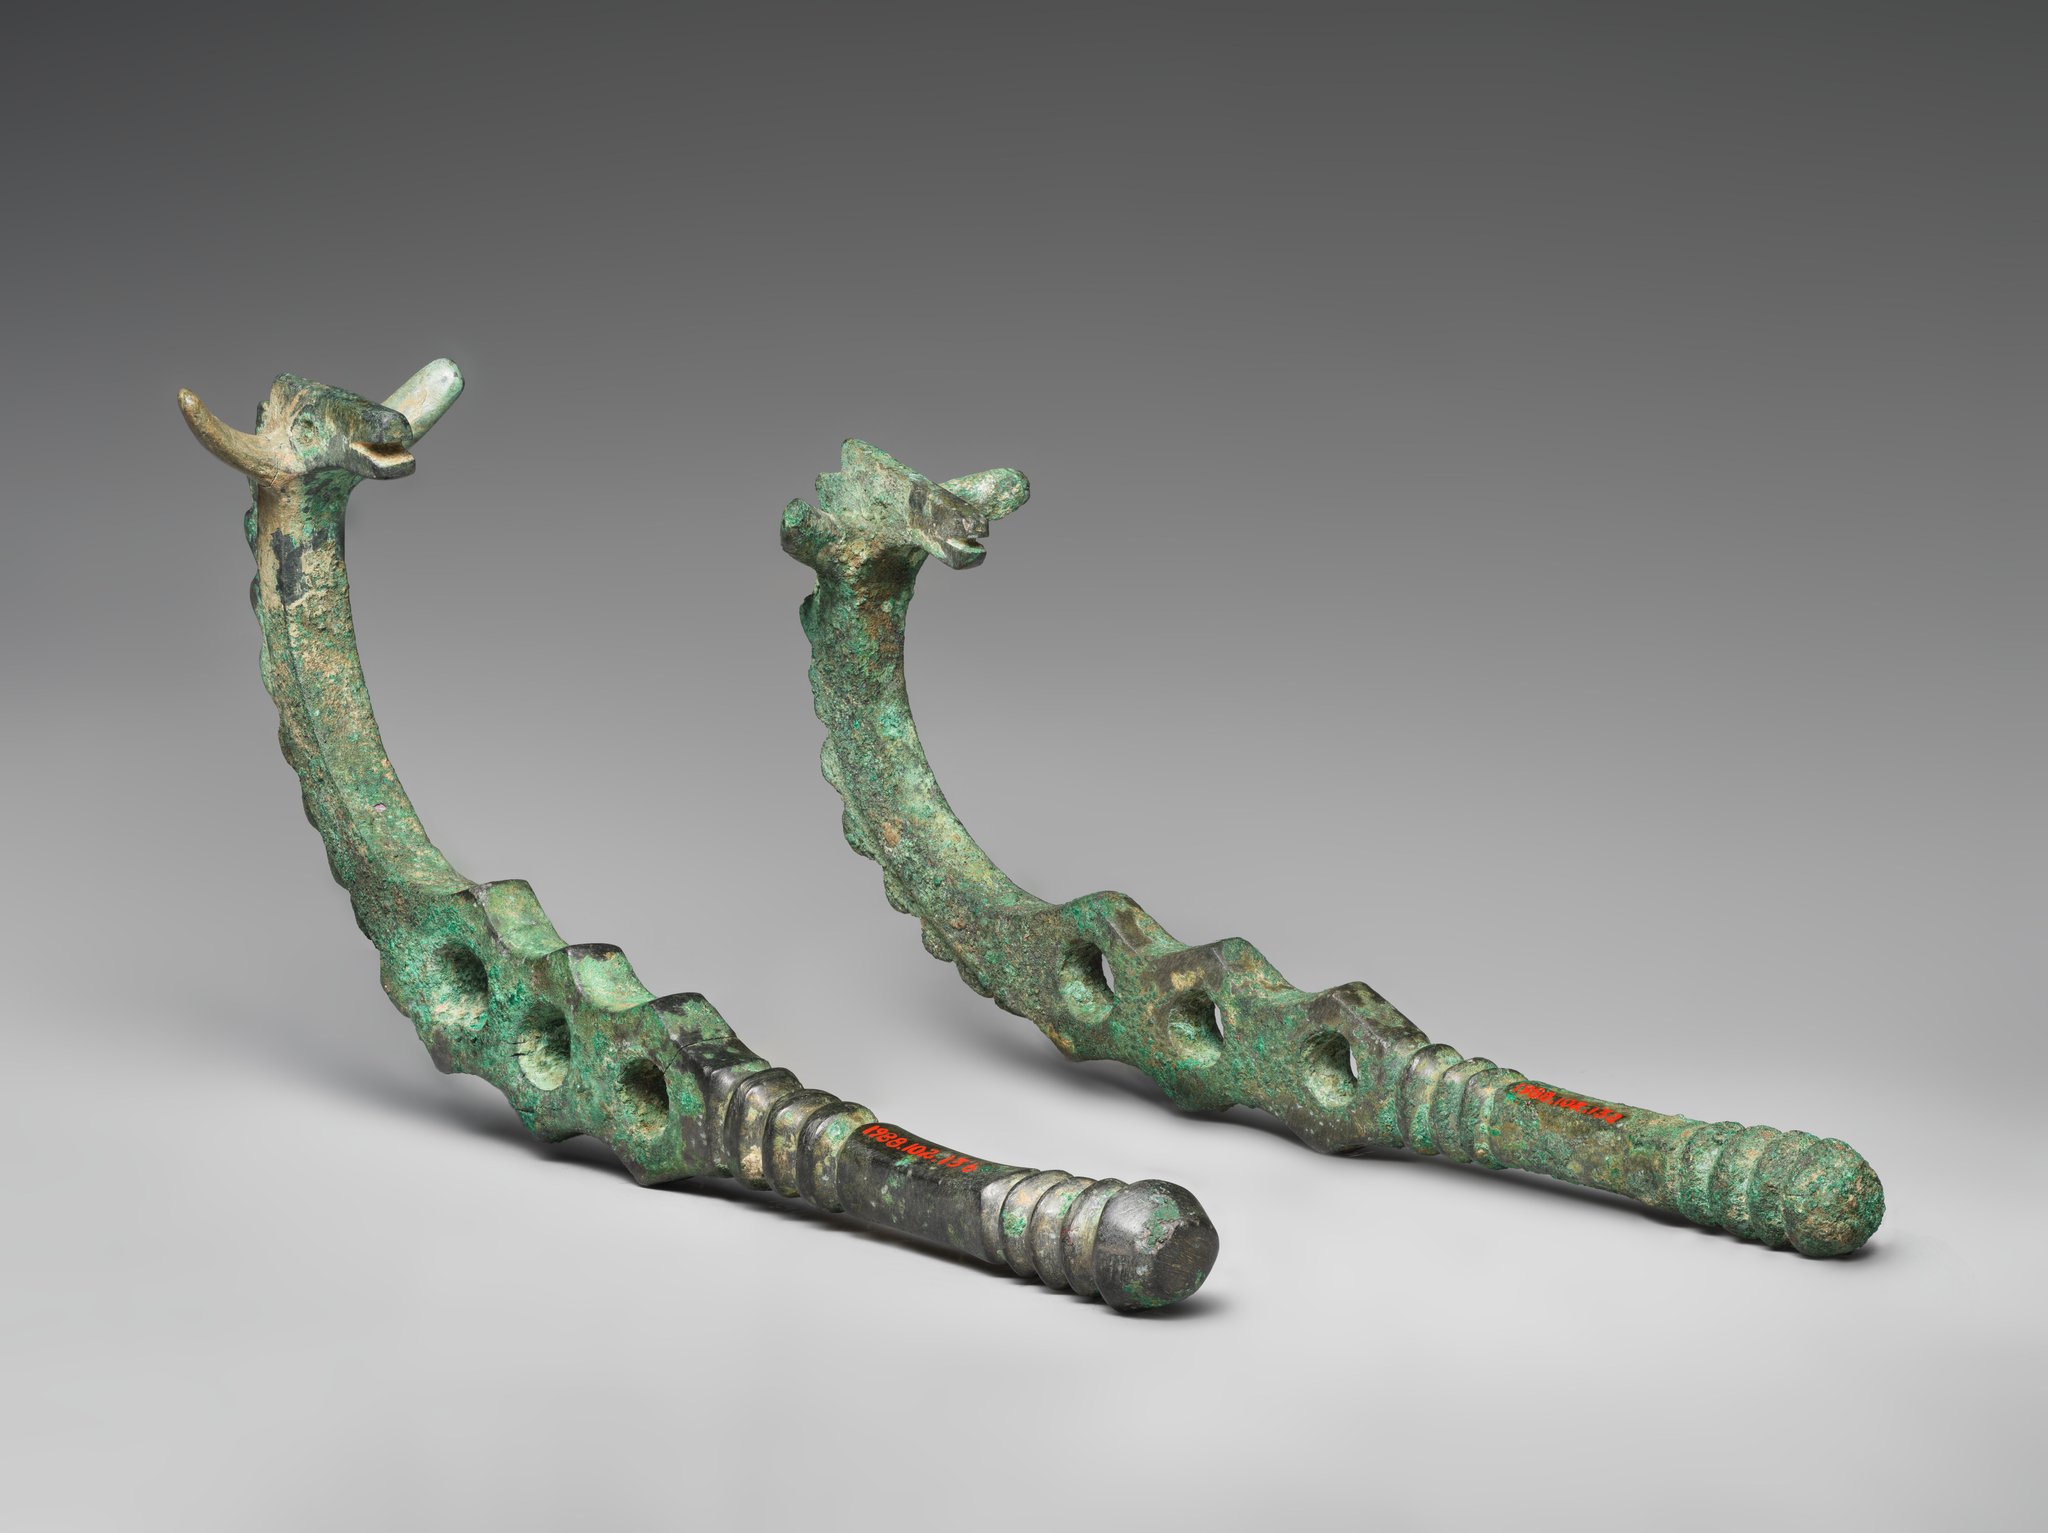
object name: horse bit cheekpiece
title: Horse bit cheekpieces in form of a horse with spiked mane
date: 1000-1 BCE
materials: bronze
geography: western iran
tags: horses